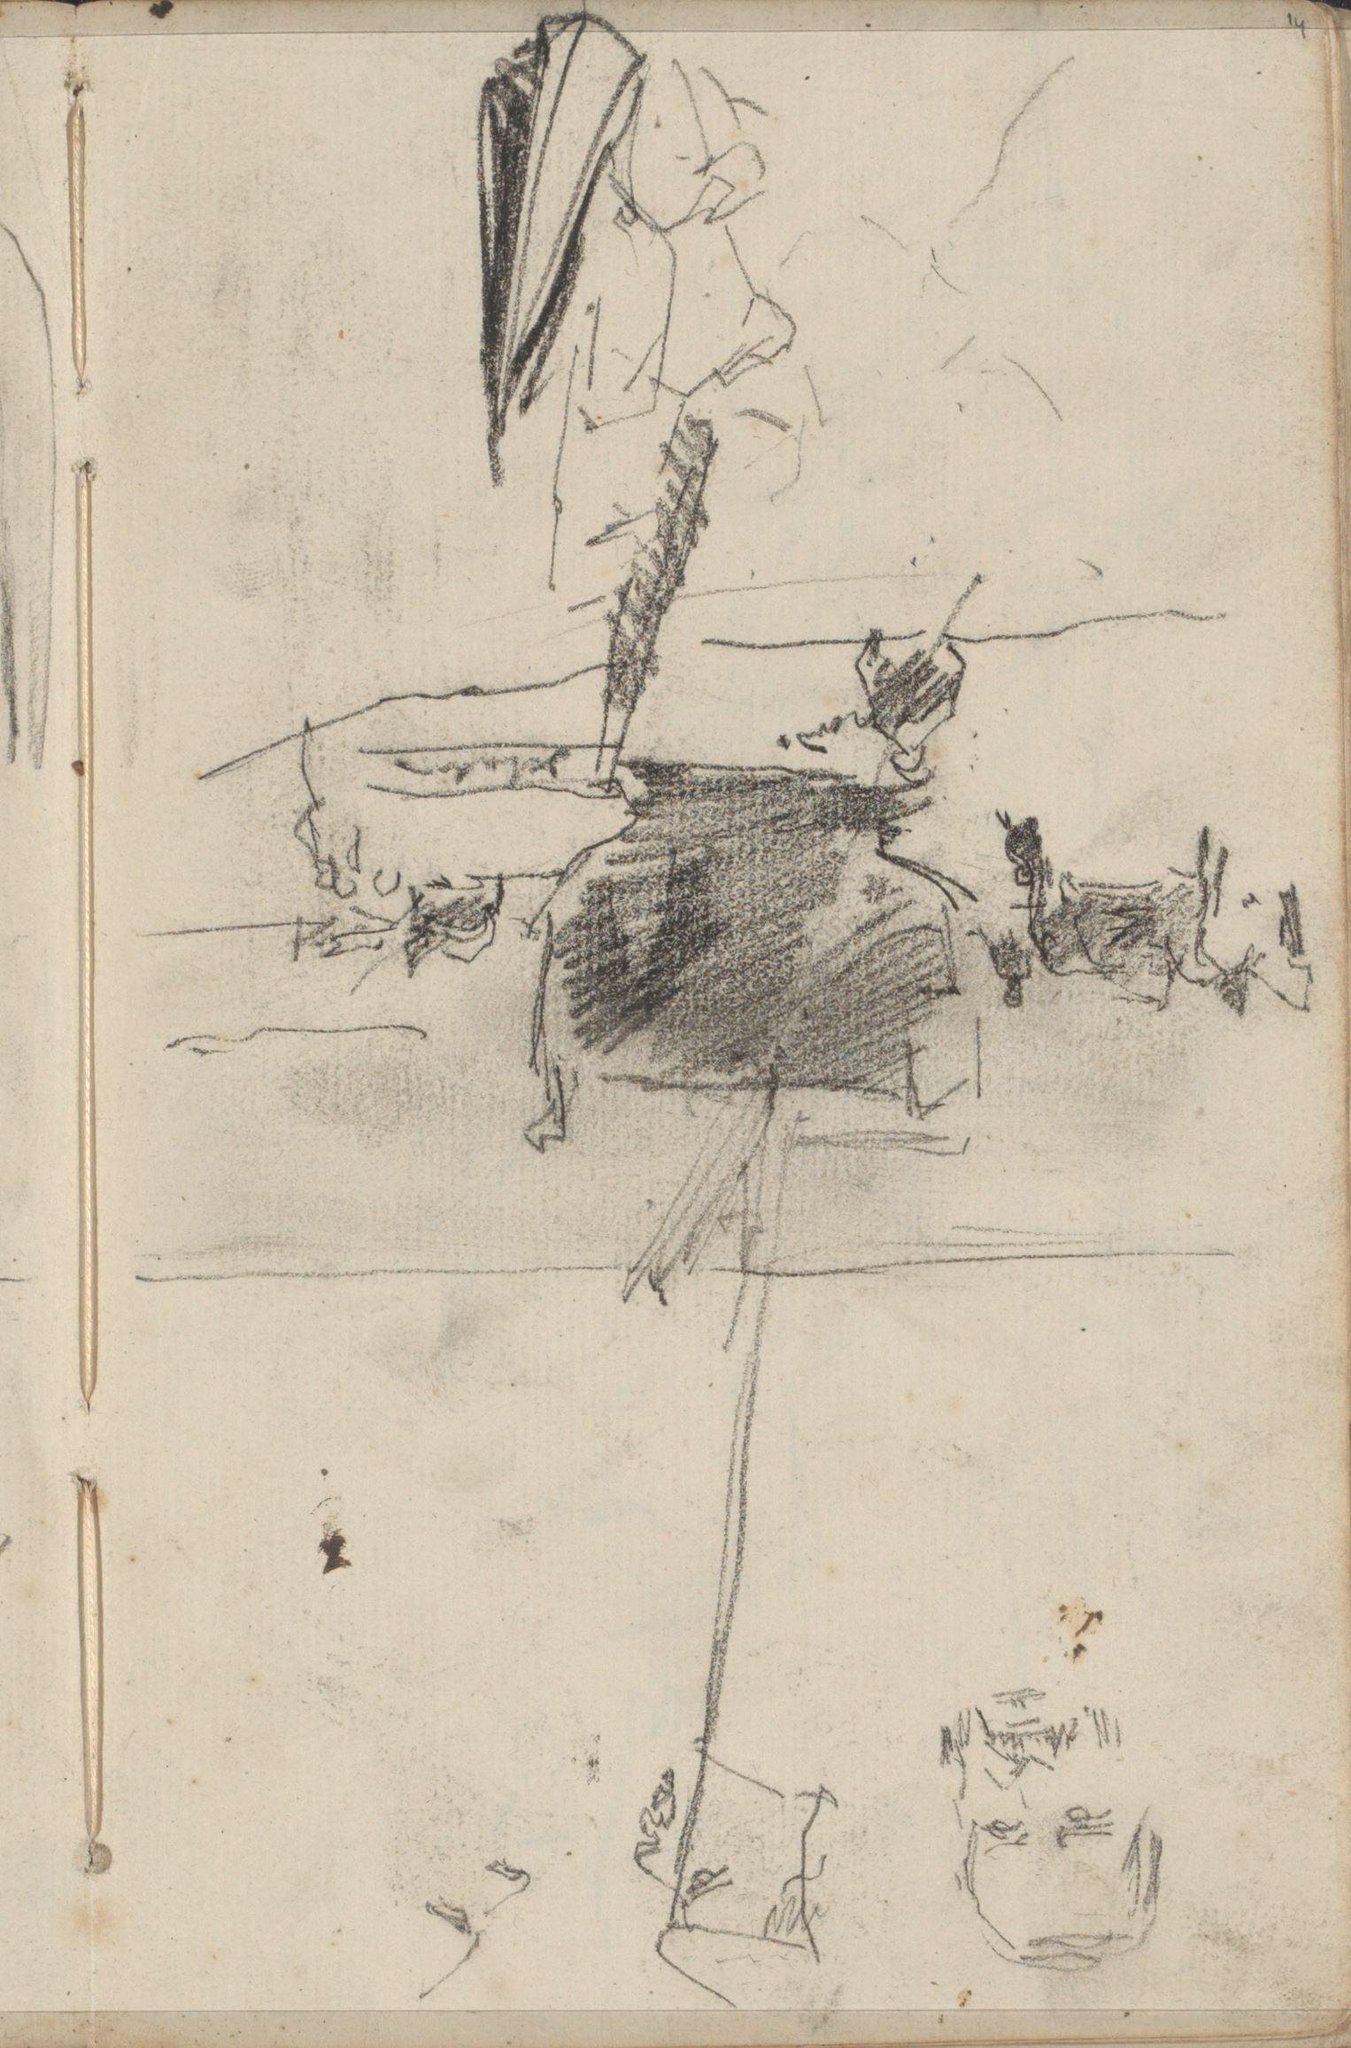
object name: sketchbook leaf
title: Mannenhoofden en een strandgezicht met een bomschuit, figuren en paarden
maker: george hendrik breitner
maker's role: draughtsman, painter, print maker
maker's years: 1857-1923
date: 1880-1882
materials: chalk, paper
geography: the hague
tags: head (human), ships (in general), horse, beach (+ landscape with figures, staffage)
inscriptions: annotation: ‘zand/ schaduw’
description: Pagina 14 uit een schetsboek met 23 bladen.